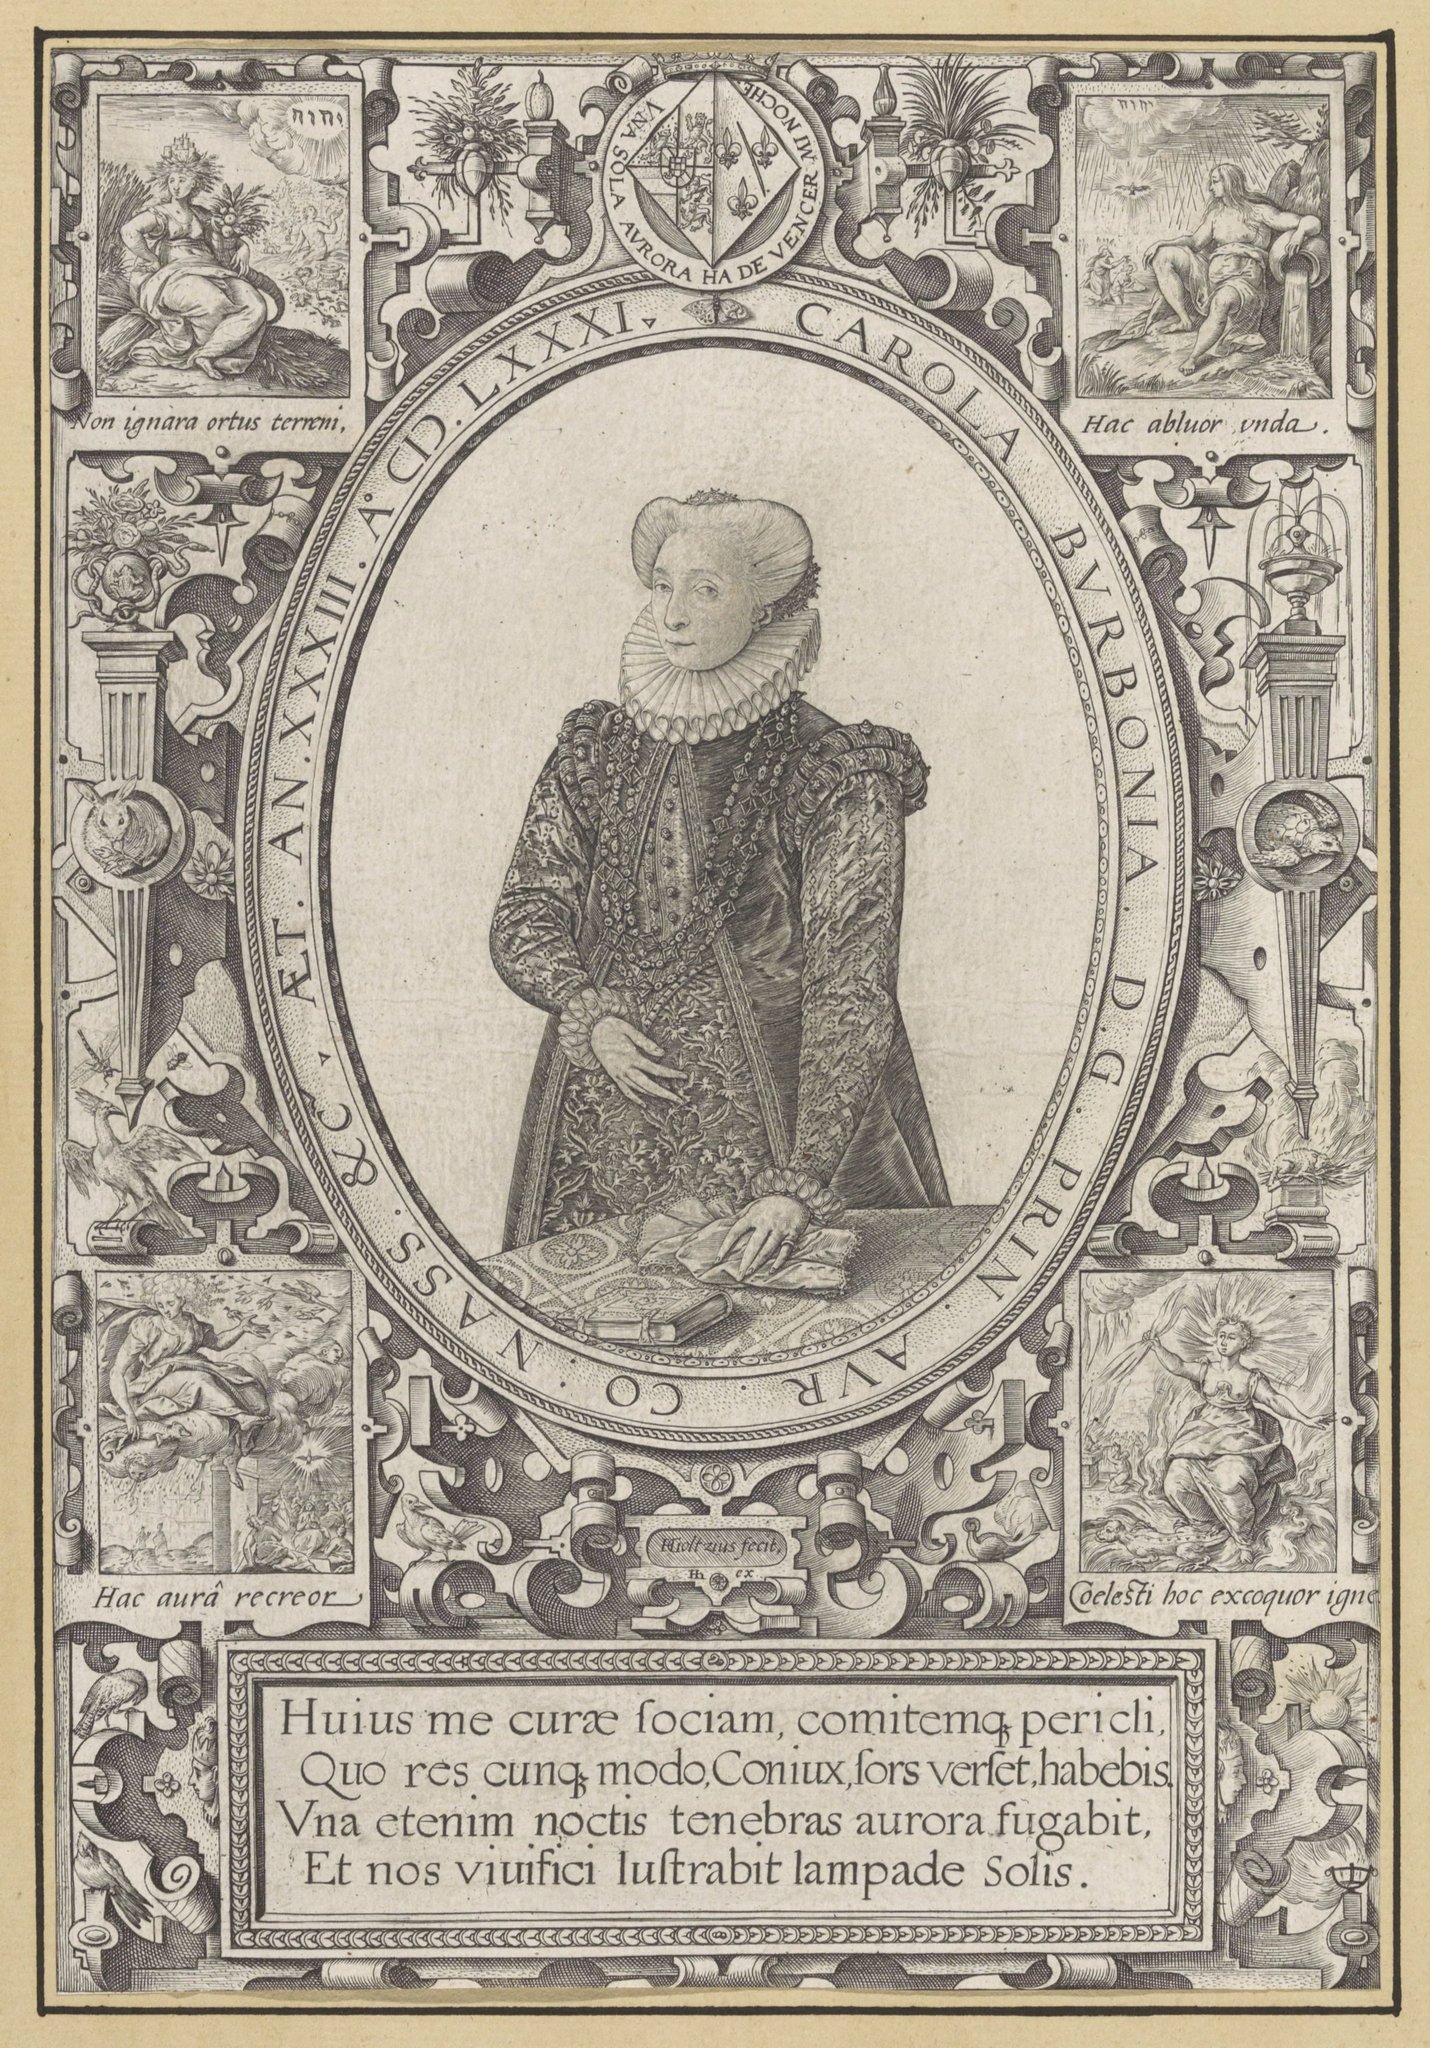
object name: print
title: Portret van Charlotte van Bourbon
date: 1597-1649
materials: paper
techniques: engraving, etching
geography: low countries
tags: antwerp, charlotte of bourbon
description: Portret van Charlotte in een ovaal met randschrift. In een kader vier regels Latijnse tekst. In de vier hoeken een Bijbelse scene.